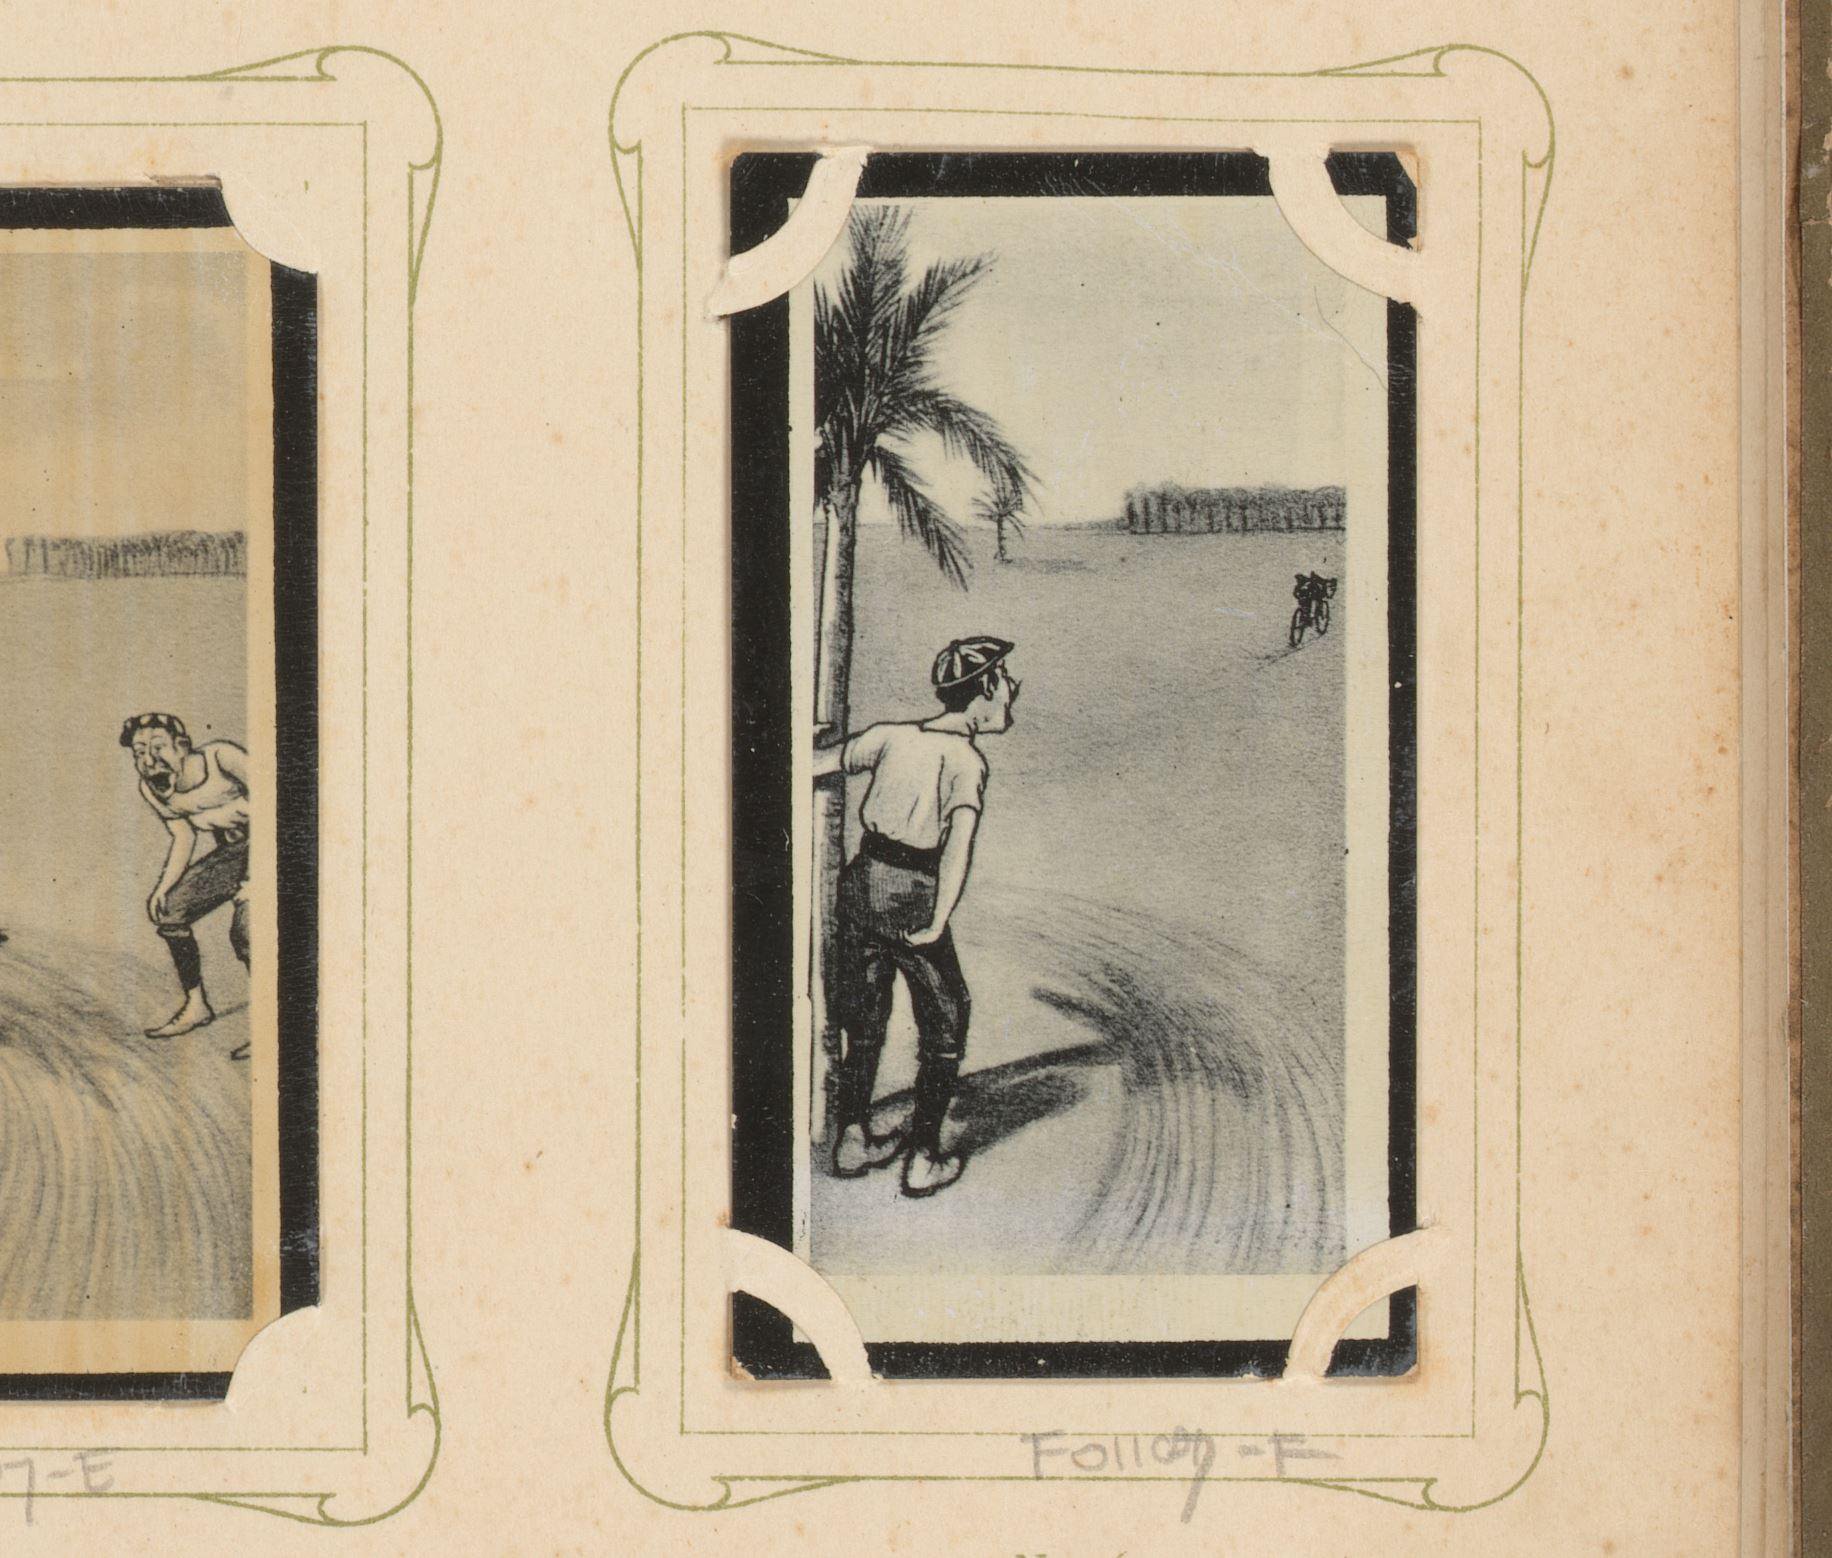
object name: reproduction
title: Reproductie van een tekening van een aap die wegfietst bij een jongen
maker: Anonymous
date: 1905-1906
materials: paper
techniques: photograph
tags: monkeys, apes, youth, adolescent, bicycle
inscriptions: inscription: ‘No. 6./ Maar O! wee! wat gebeurd er nu.’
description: Deze prent maakt deel uit van een album.